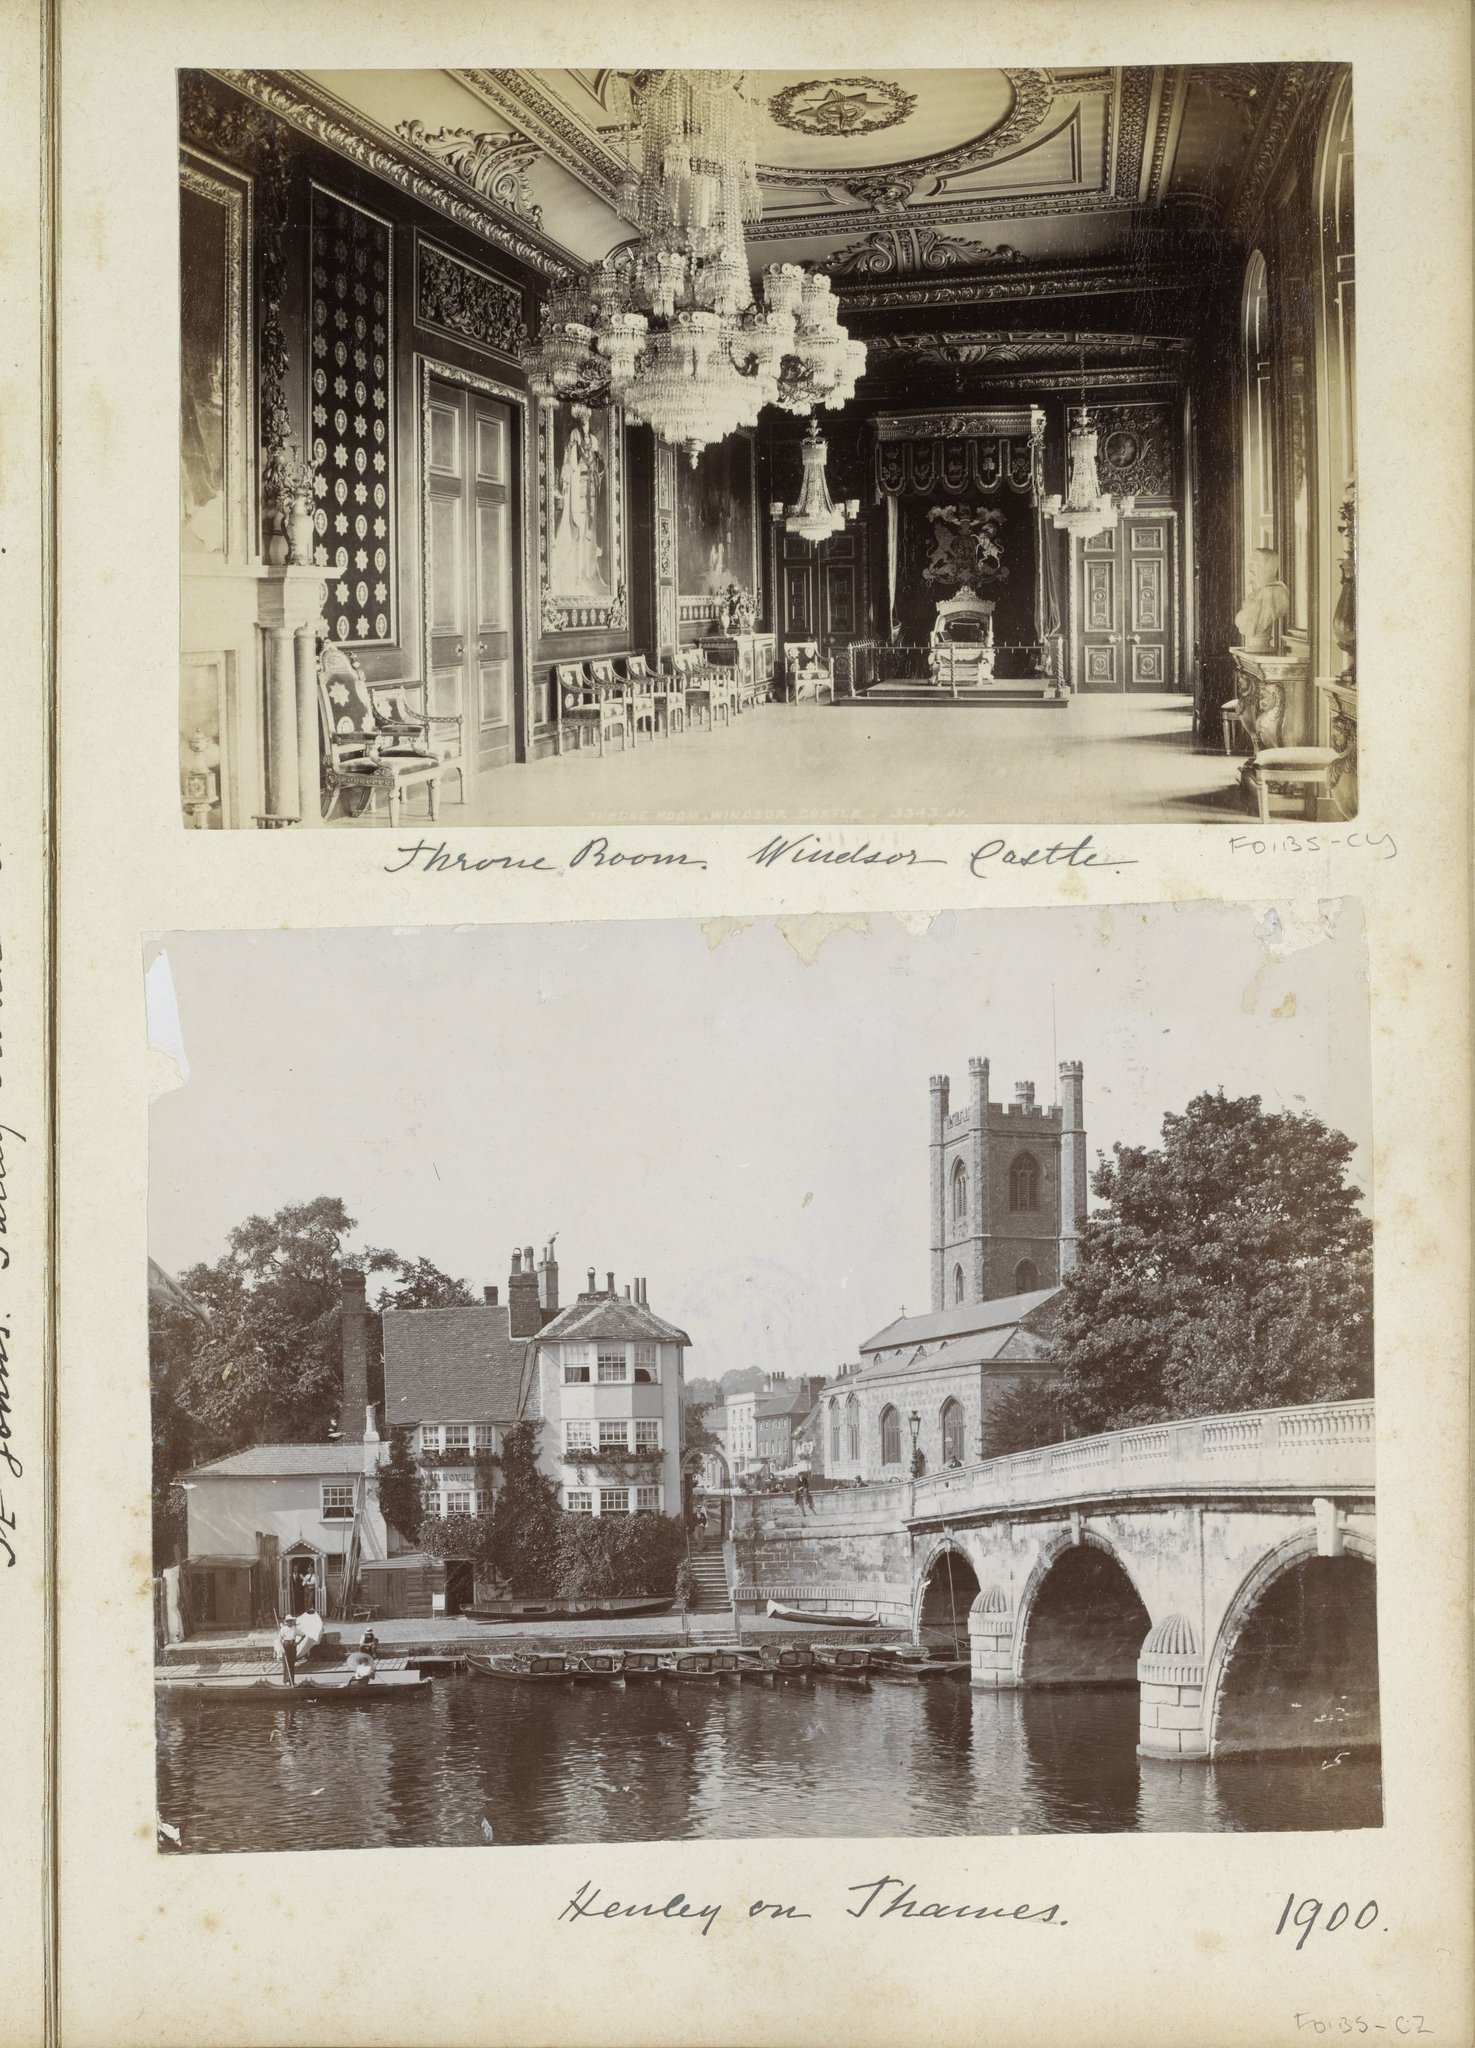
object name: album leaf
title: Gezicht op Henley-on-Thames met rechts een brug en de toren van St Mary's Church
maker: Anonymous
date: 1900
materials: paper, photographic support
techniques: albumen print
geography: henley-on-thames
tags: prospect of village, silhouette of village, rowing-boat, canoe, etc., bridge, parts of church exterior and annexes: tower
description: Onderdeel van Reisalbum met foto's van bezienswaardigheden in Engeland en Frankrijk.